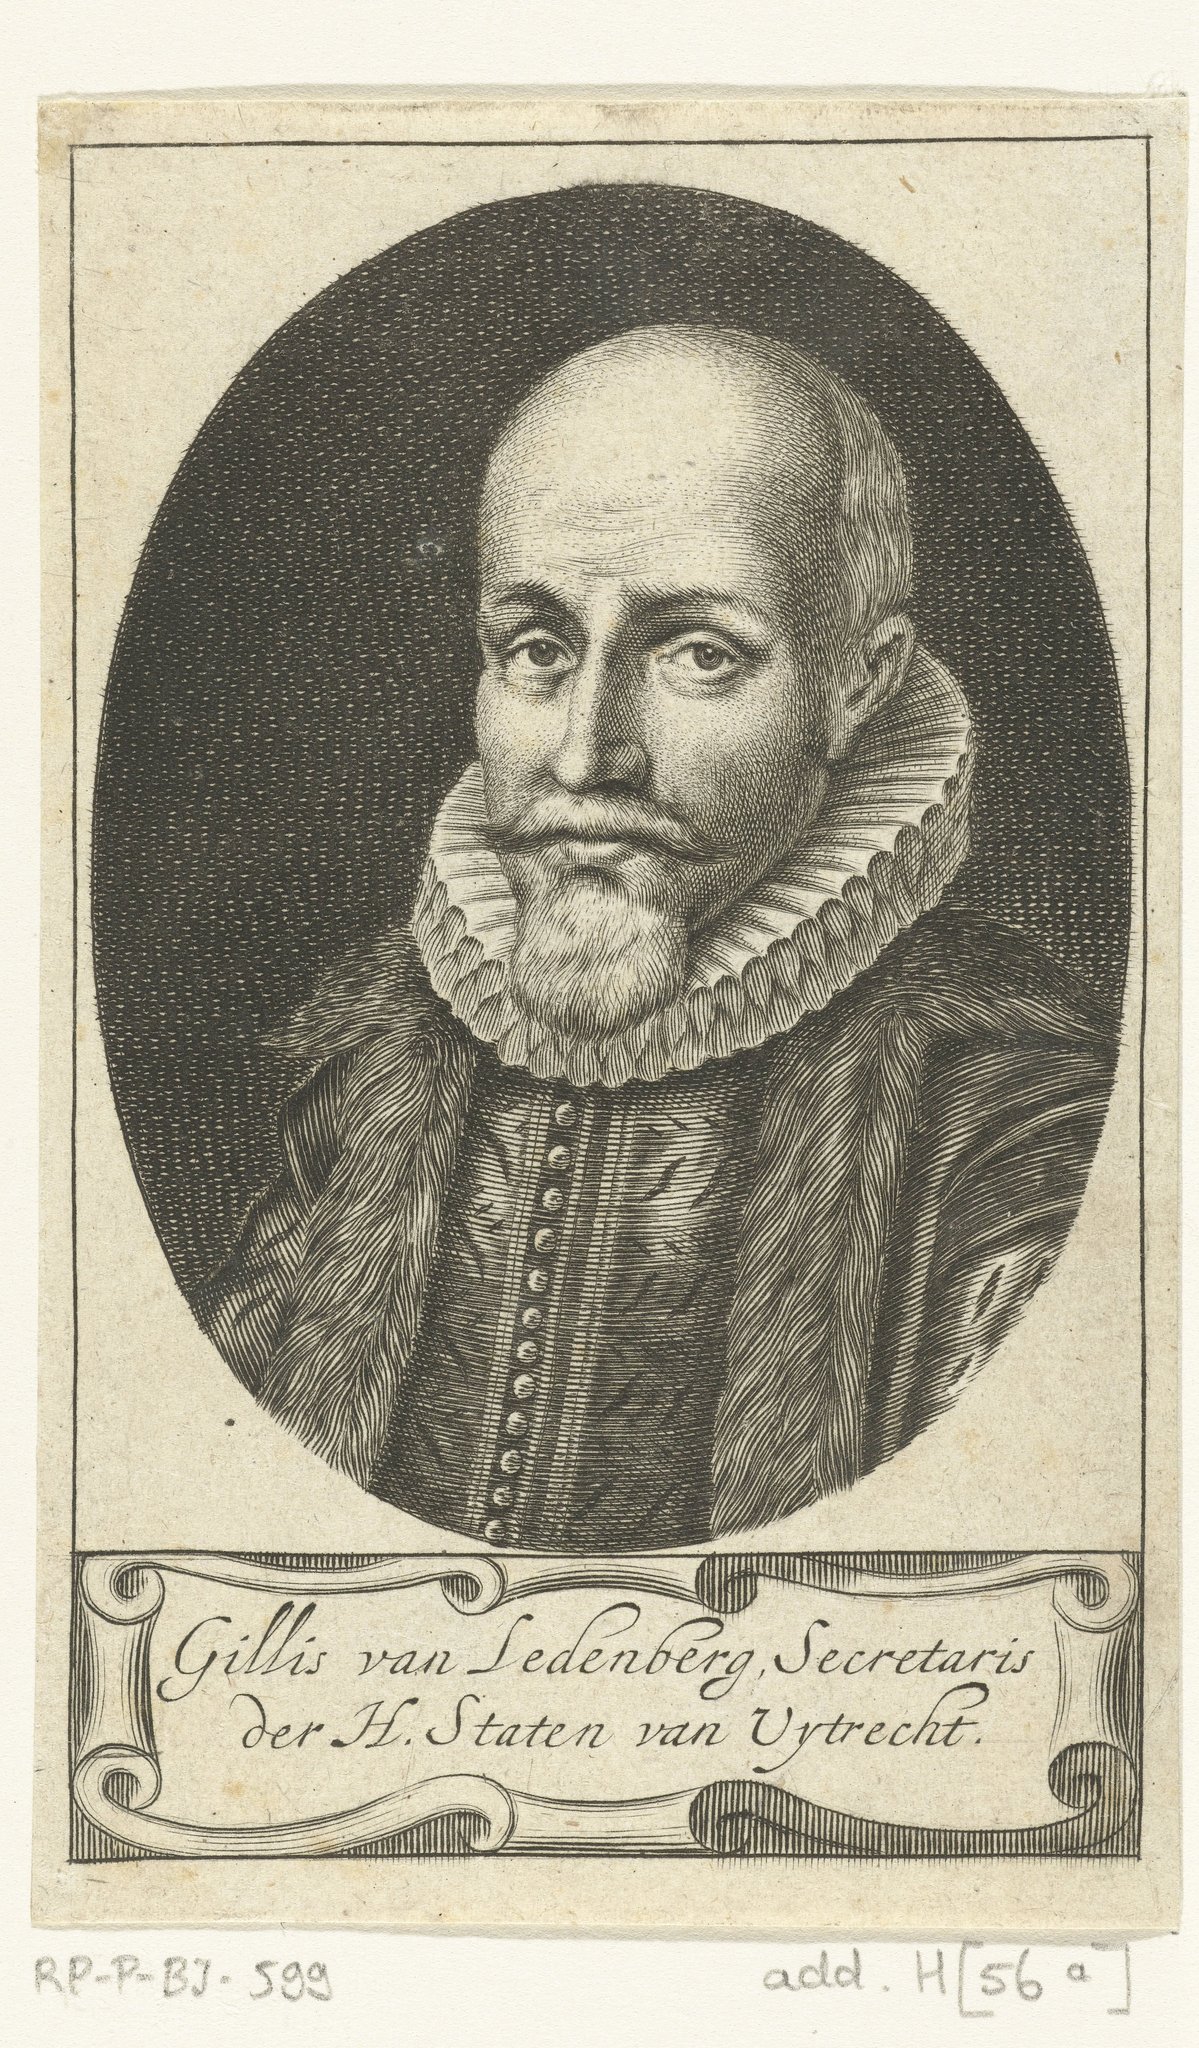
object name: print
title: Portret van Gilles van Ledenberg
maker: hendrik bary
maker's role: draughtsman, print maker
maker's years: 1640-1707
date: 1657-1707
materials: paper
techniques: engraving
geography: netherlands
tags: utrecht, the hague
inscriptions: collector's mark: Lugt 2228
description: Portret van Gilles van Ledenberg met kaal hoofd. Onder het portret een cartouche met zijn naam en functie.